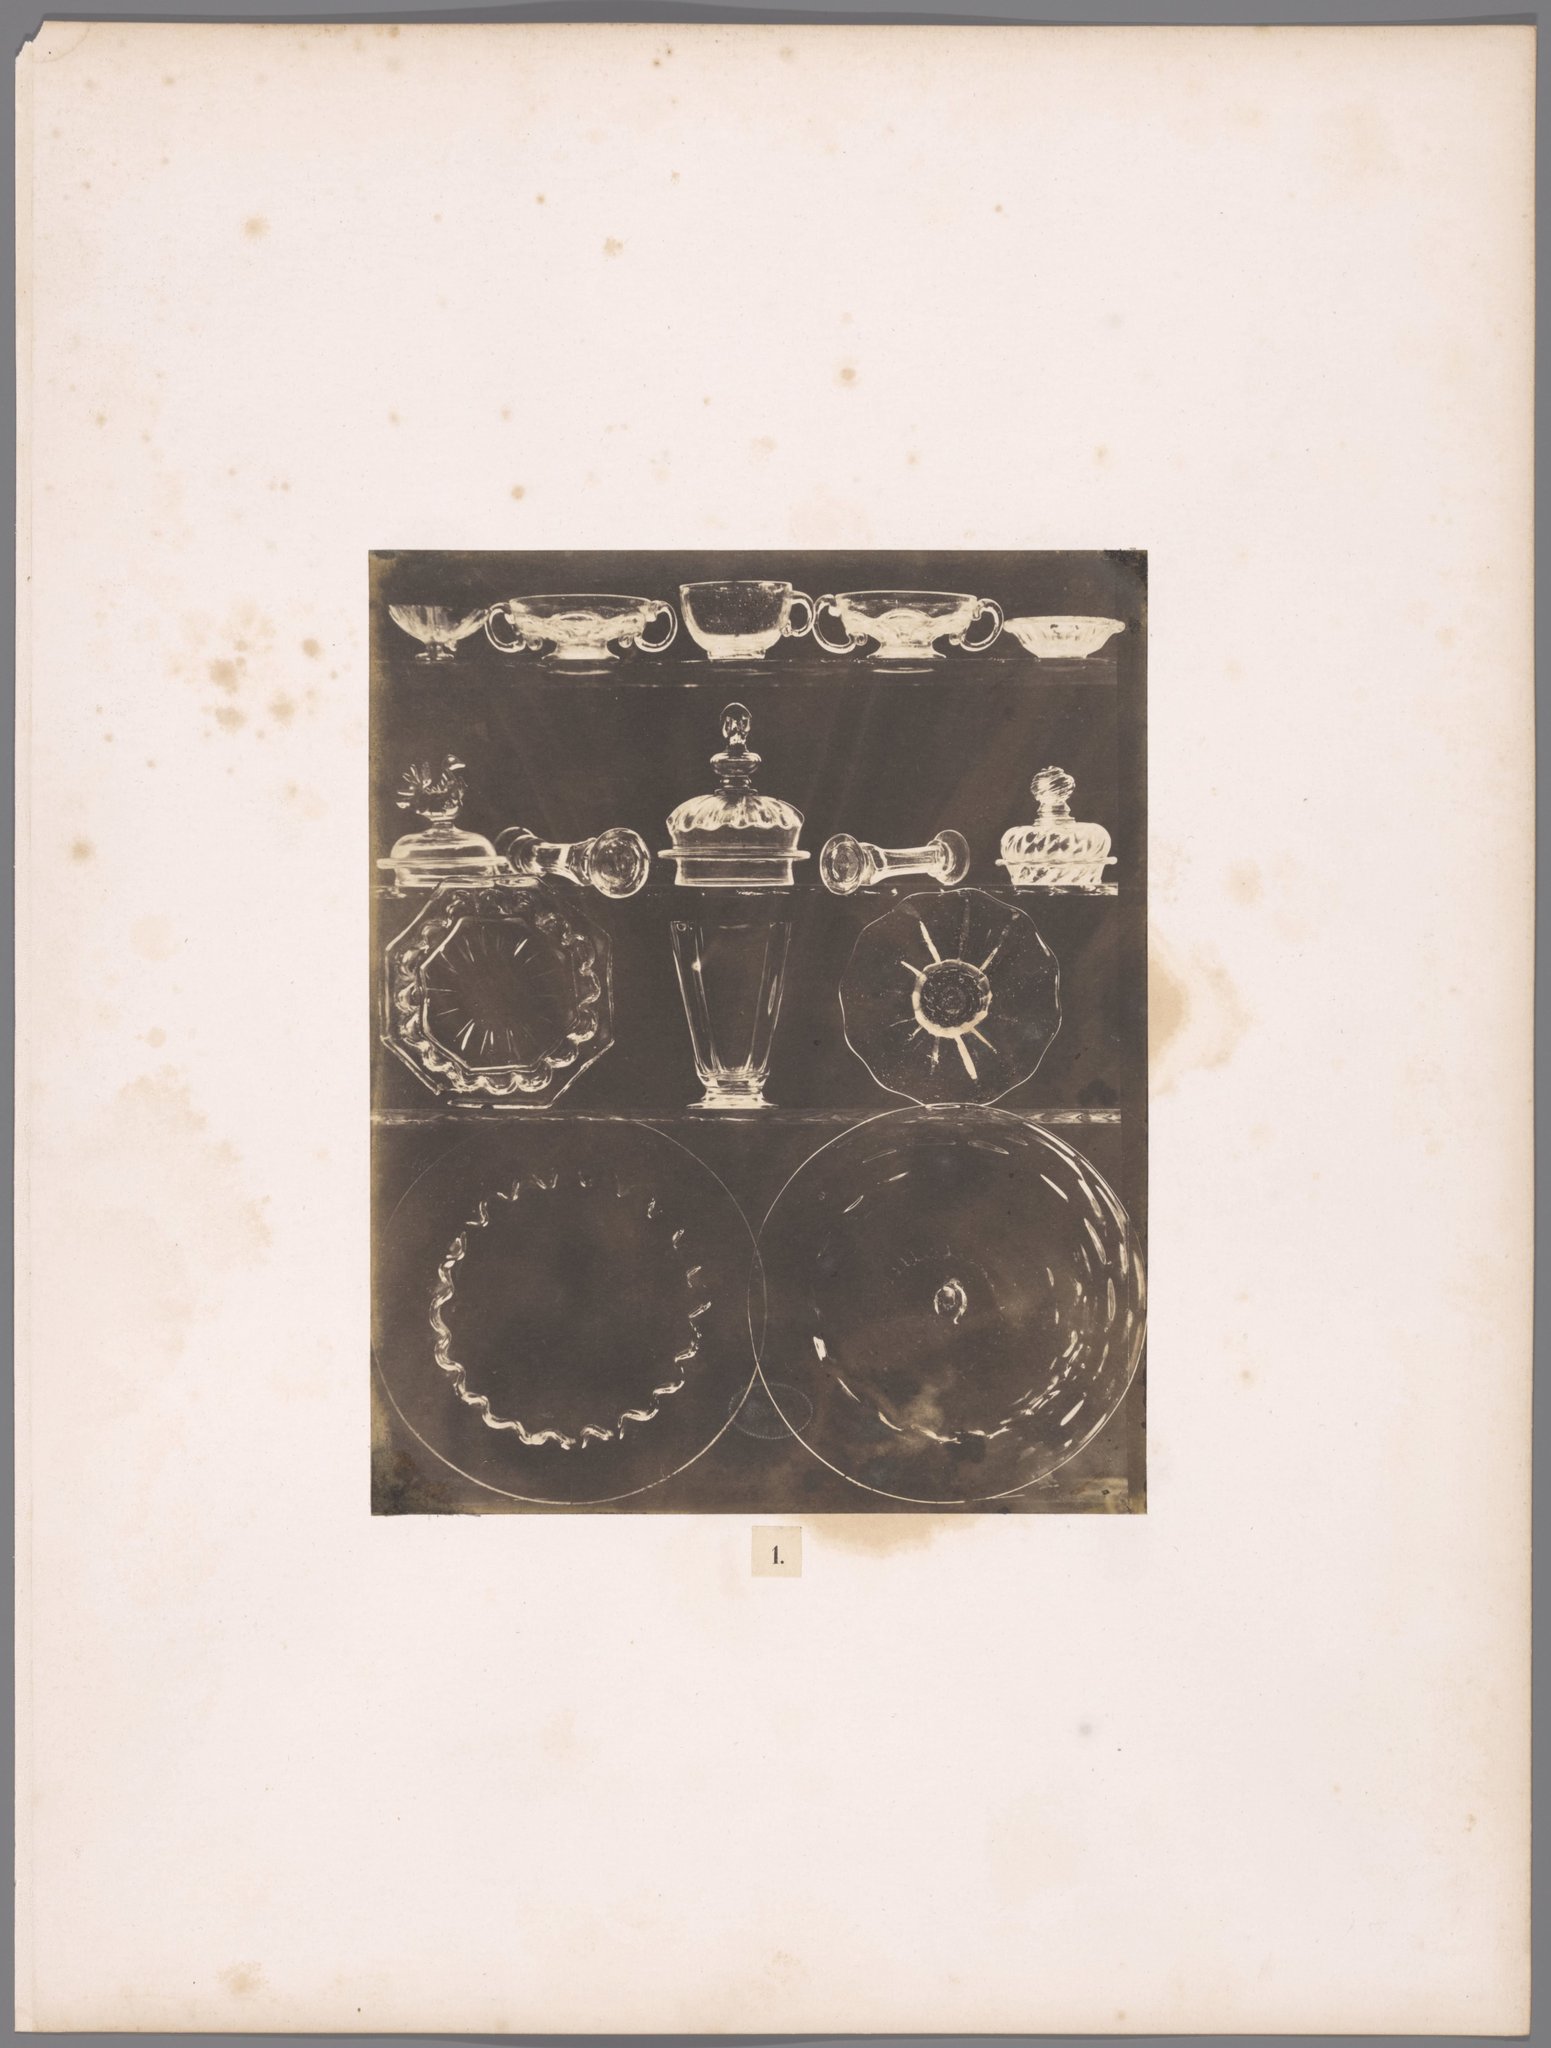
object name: photograph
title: Glassware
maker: ludwig belitski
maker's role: fotograaf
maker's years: 1830-1902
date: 1854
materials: paper, photographic support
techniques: albumen print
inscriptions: label: ‘1’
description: This photograph is part of a large series assembled by Baron Alexander von Minutoli in the early 1850s. By means of good examples, he hoped to improve the quality of the production of glassware in his place of residence Liegnitz (now Legnica, Poland). All of the photographs in the series had to be hand-printed, hence they were ultimately much too expensive to reach the intended public.